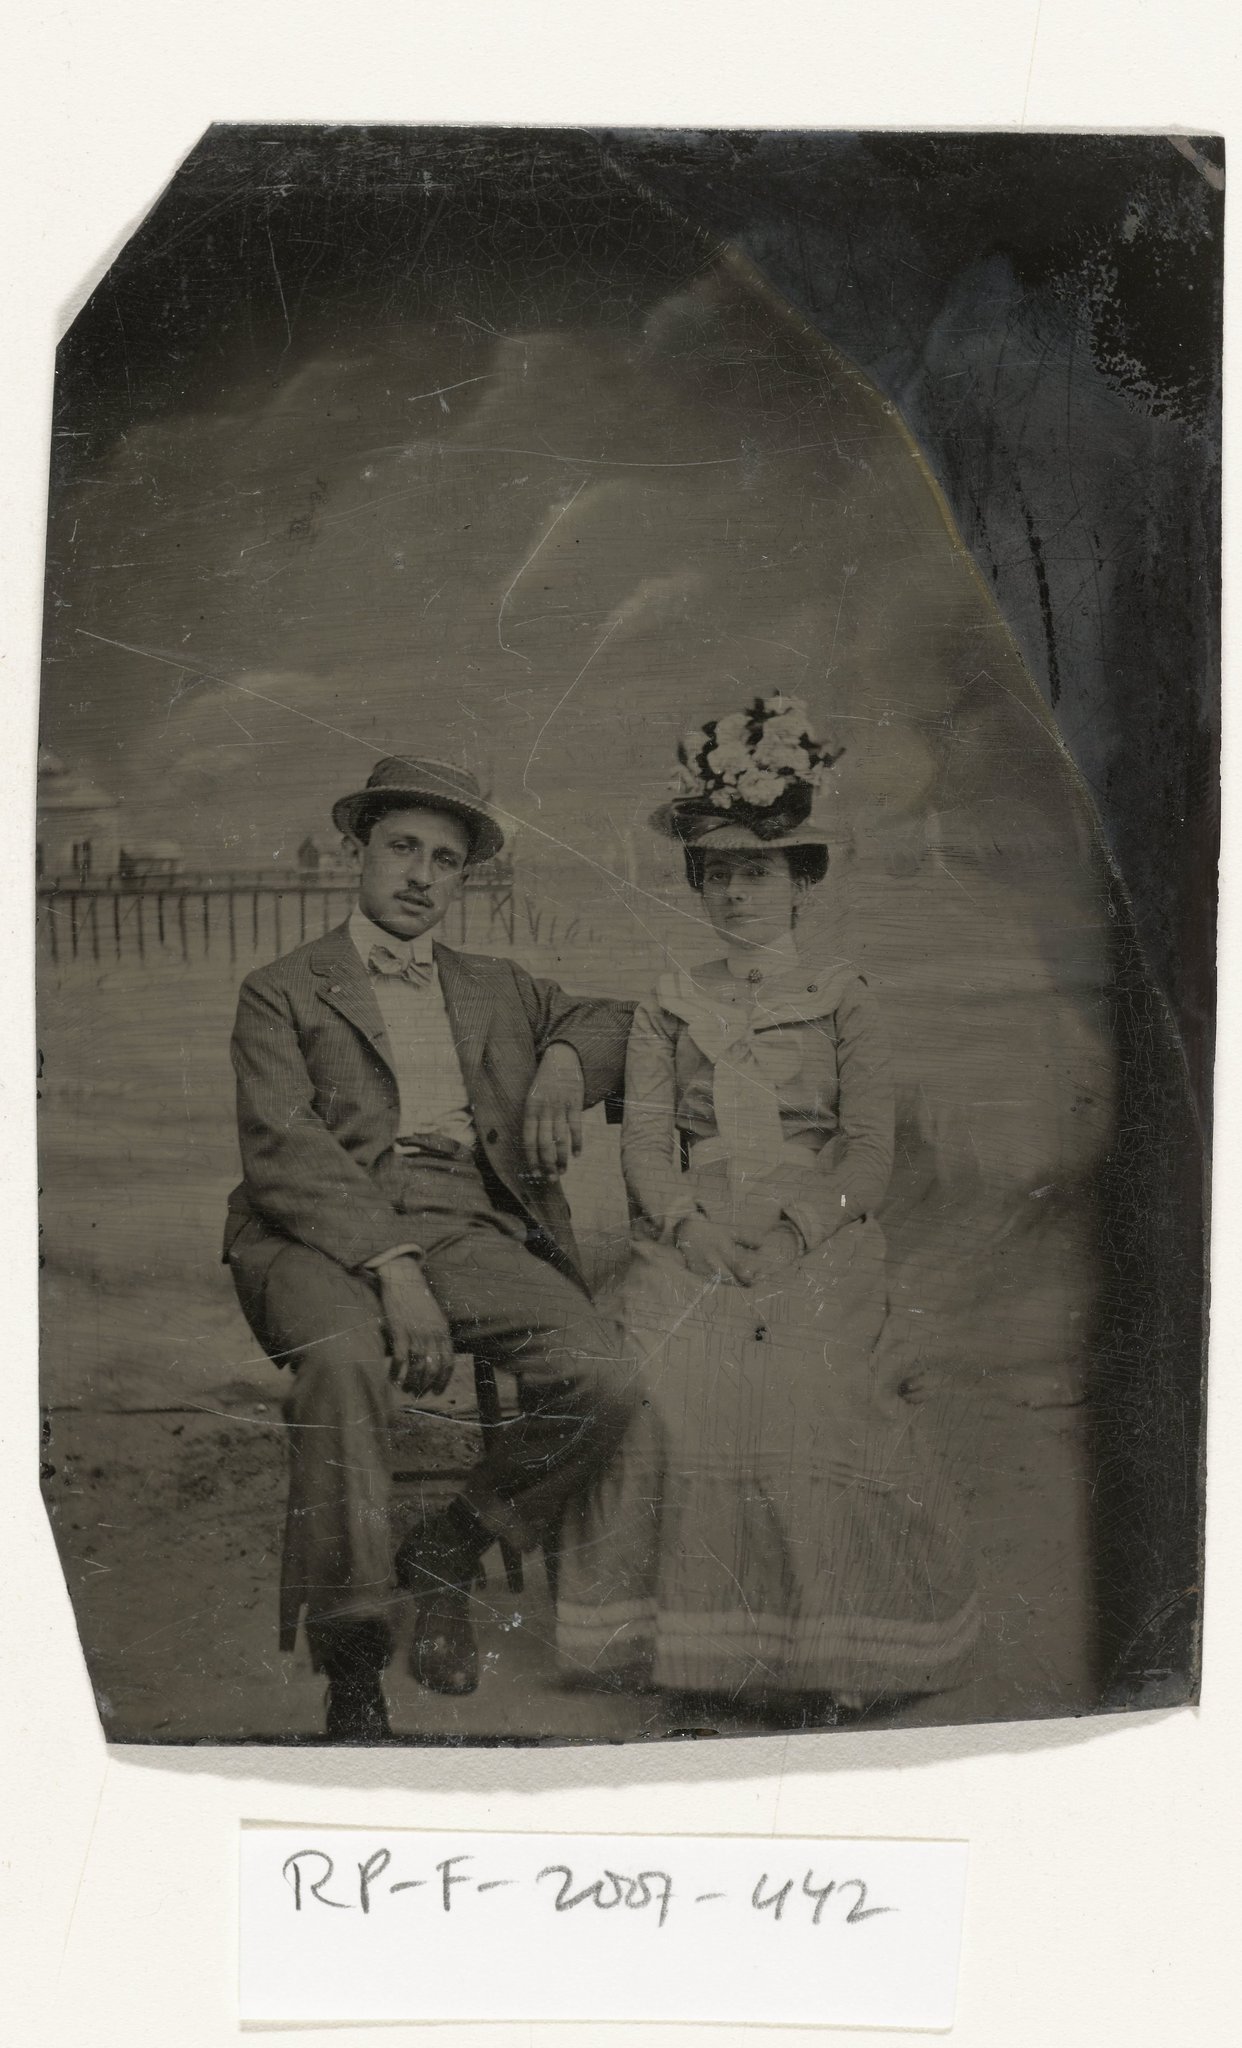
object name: photograph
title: Portret van een man en vrouw, zittend voor een geschilderd achtergronddoek (strand, zee en pier)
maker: Anonymous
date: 1880-1910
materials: metal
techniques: ferrotyping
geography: united states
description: in rechter bovenhoek ontbreekt de emulsie